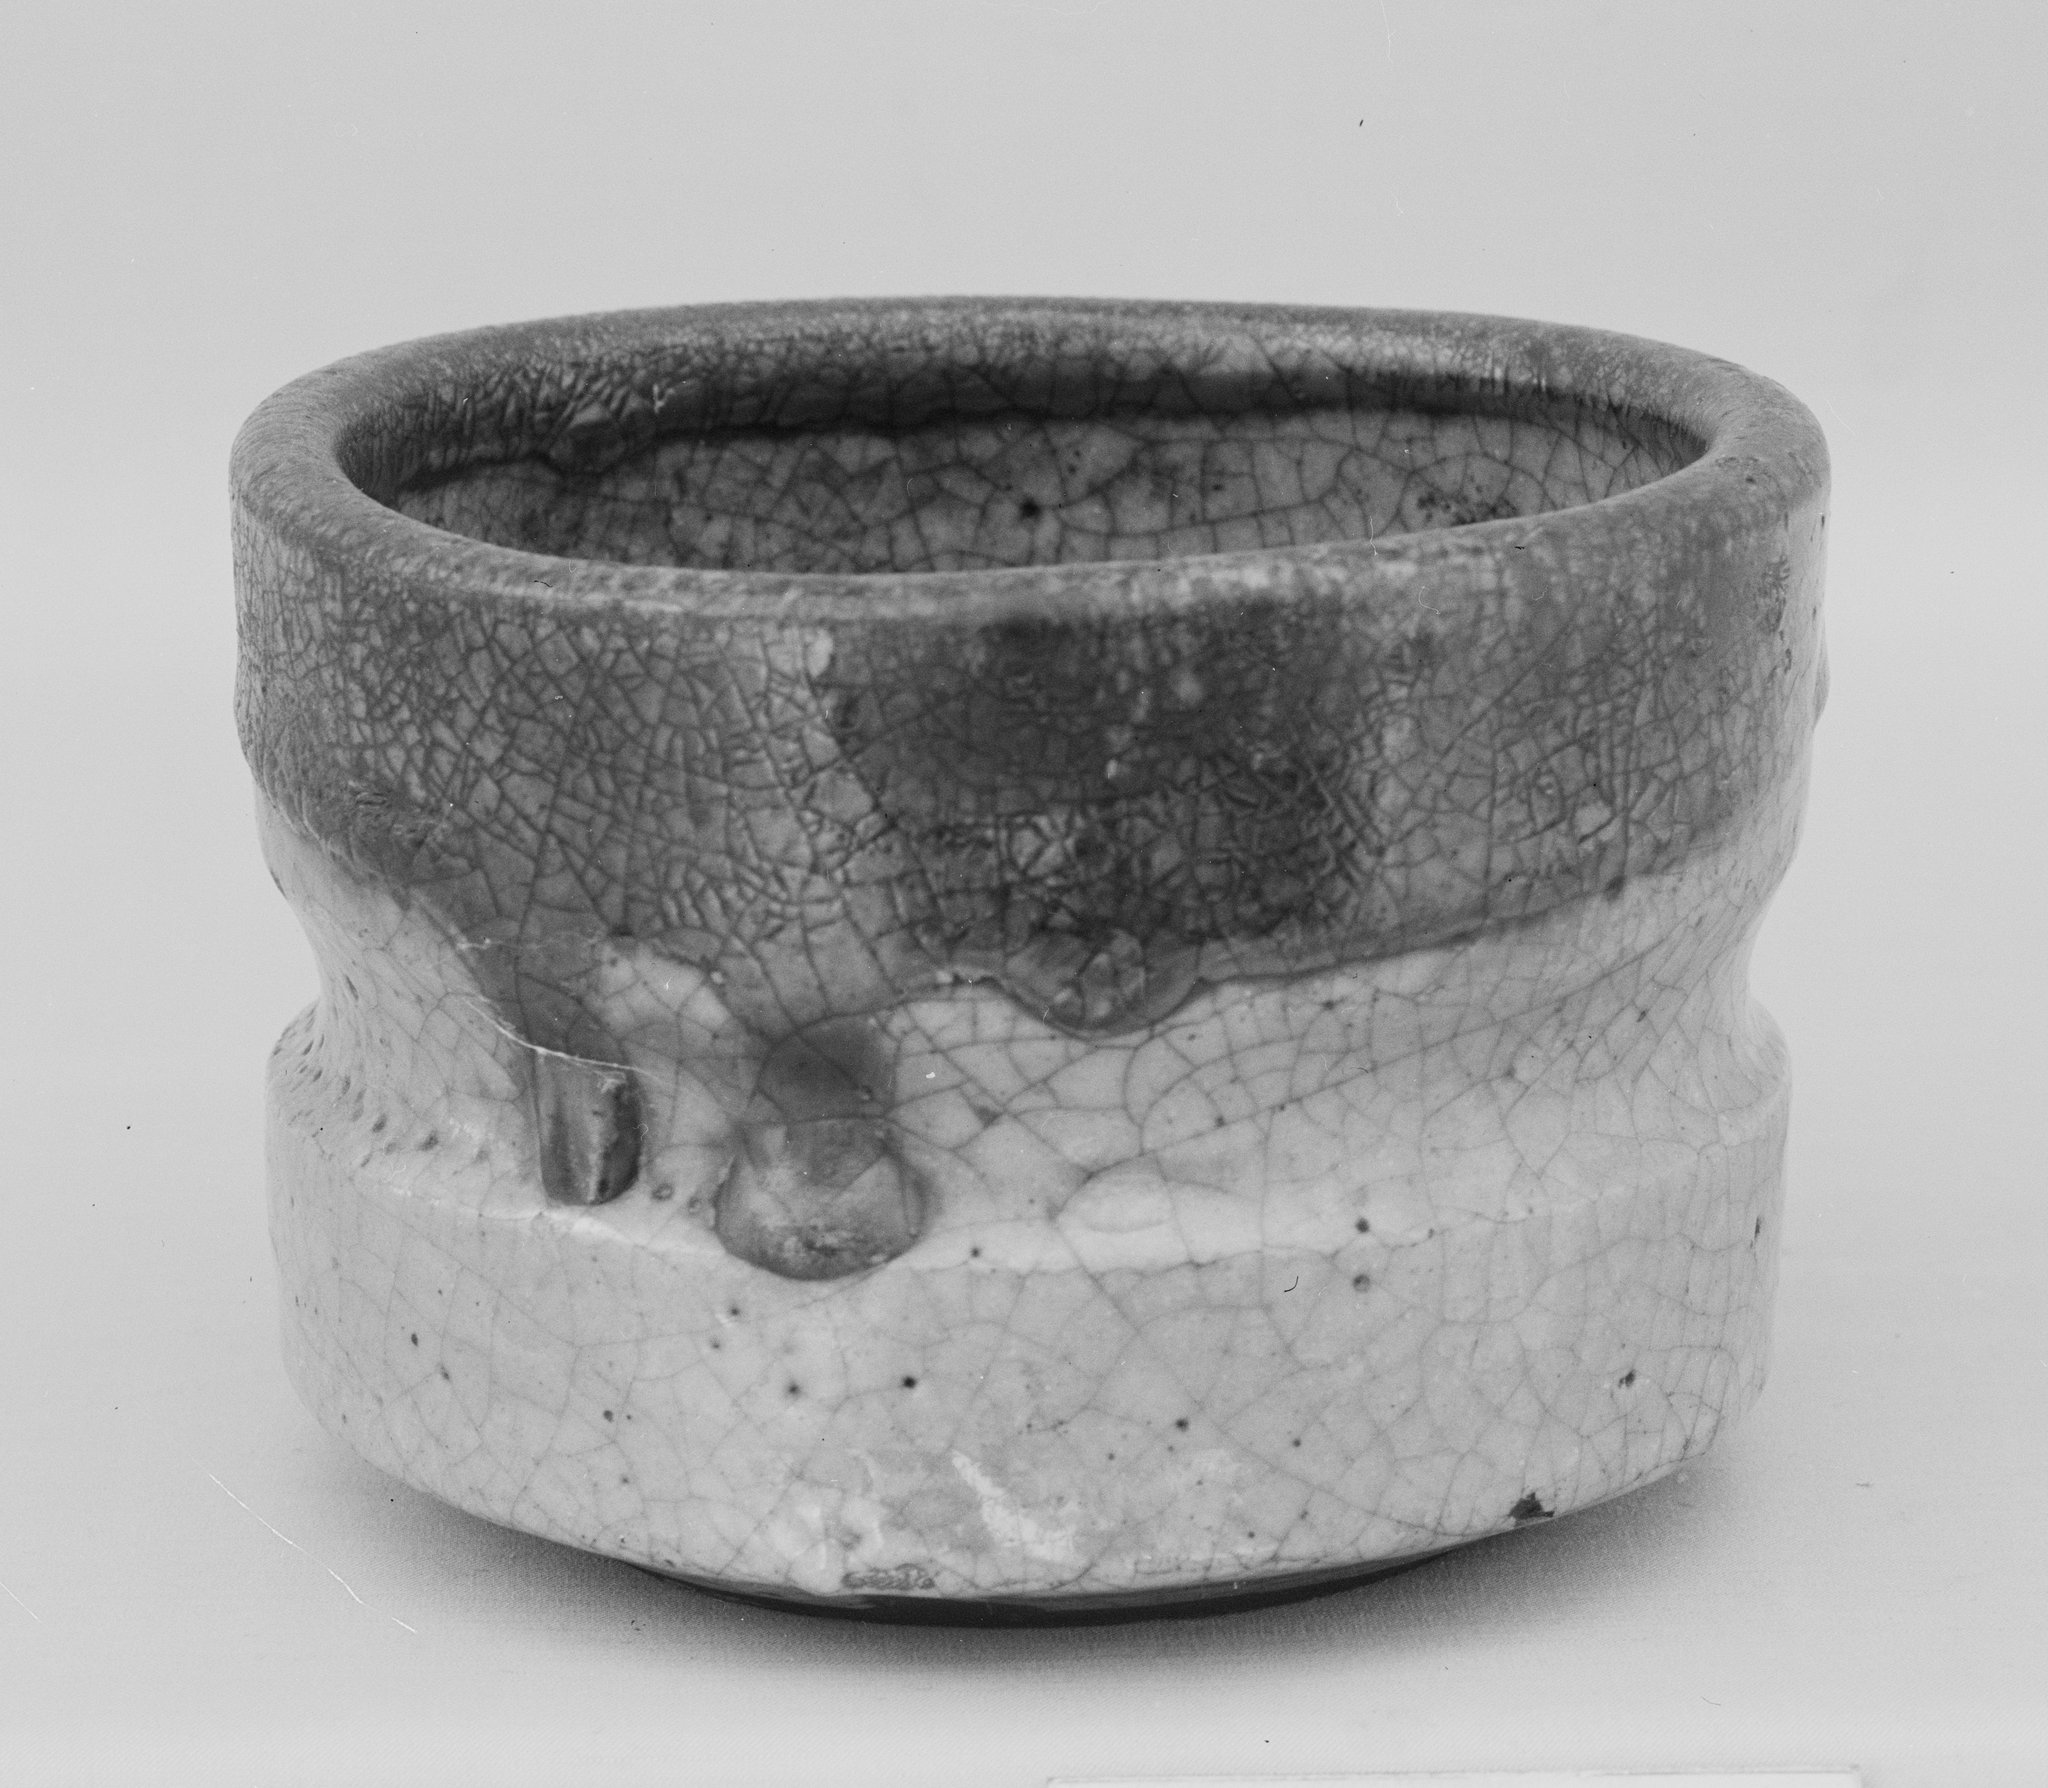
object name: fire bowl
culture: japanese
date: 1801-1900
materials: glaze, paste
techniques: overglaze